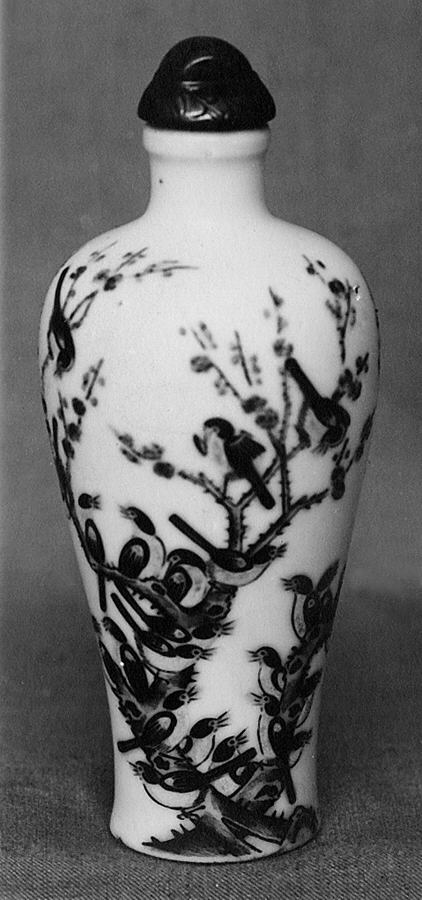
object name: snuff bottle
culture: chinese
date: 1736-1795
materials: porcelain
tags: birds